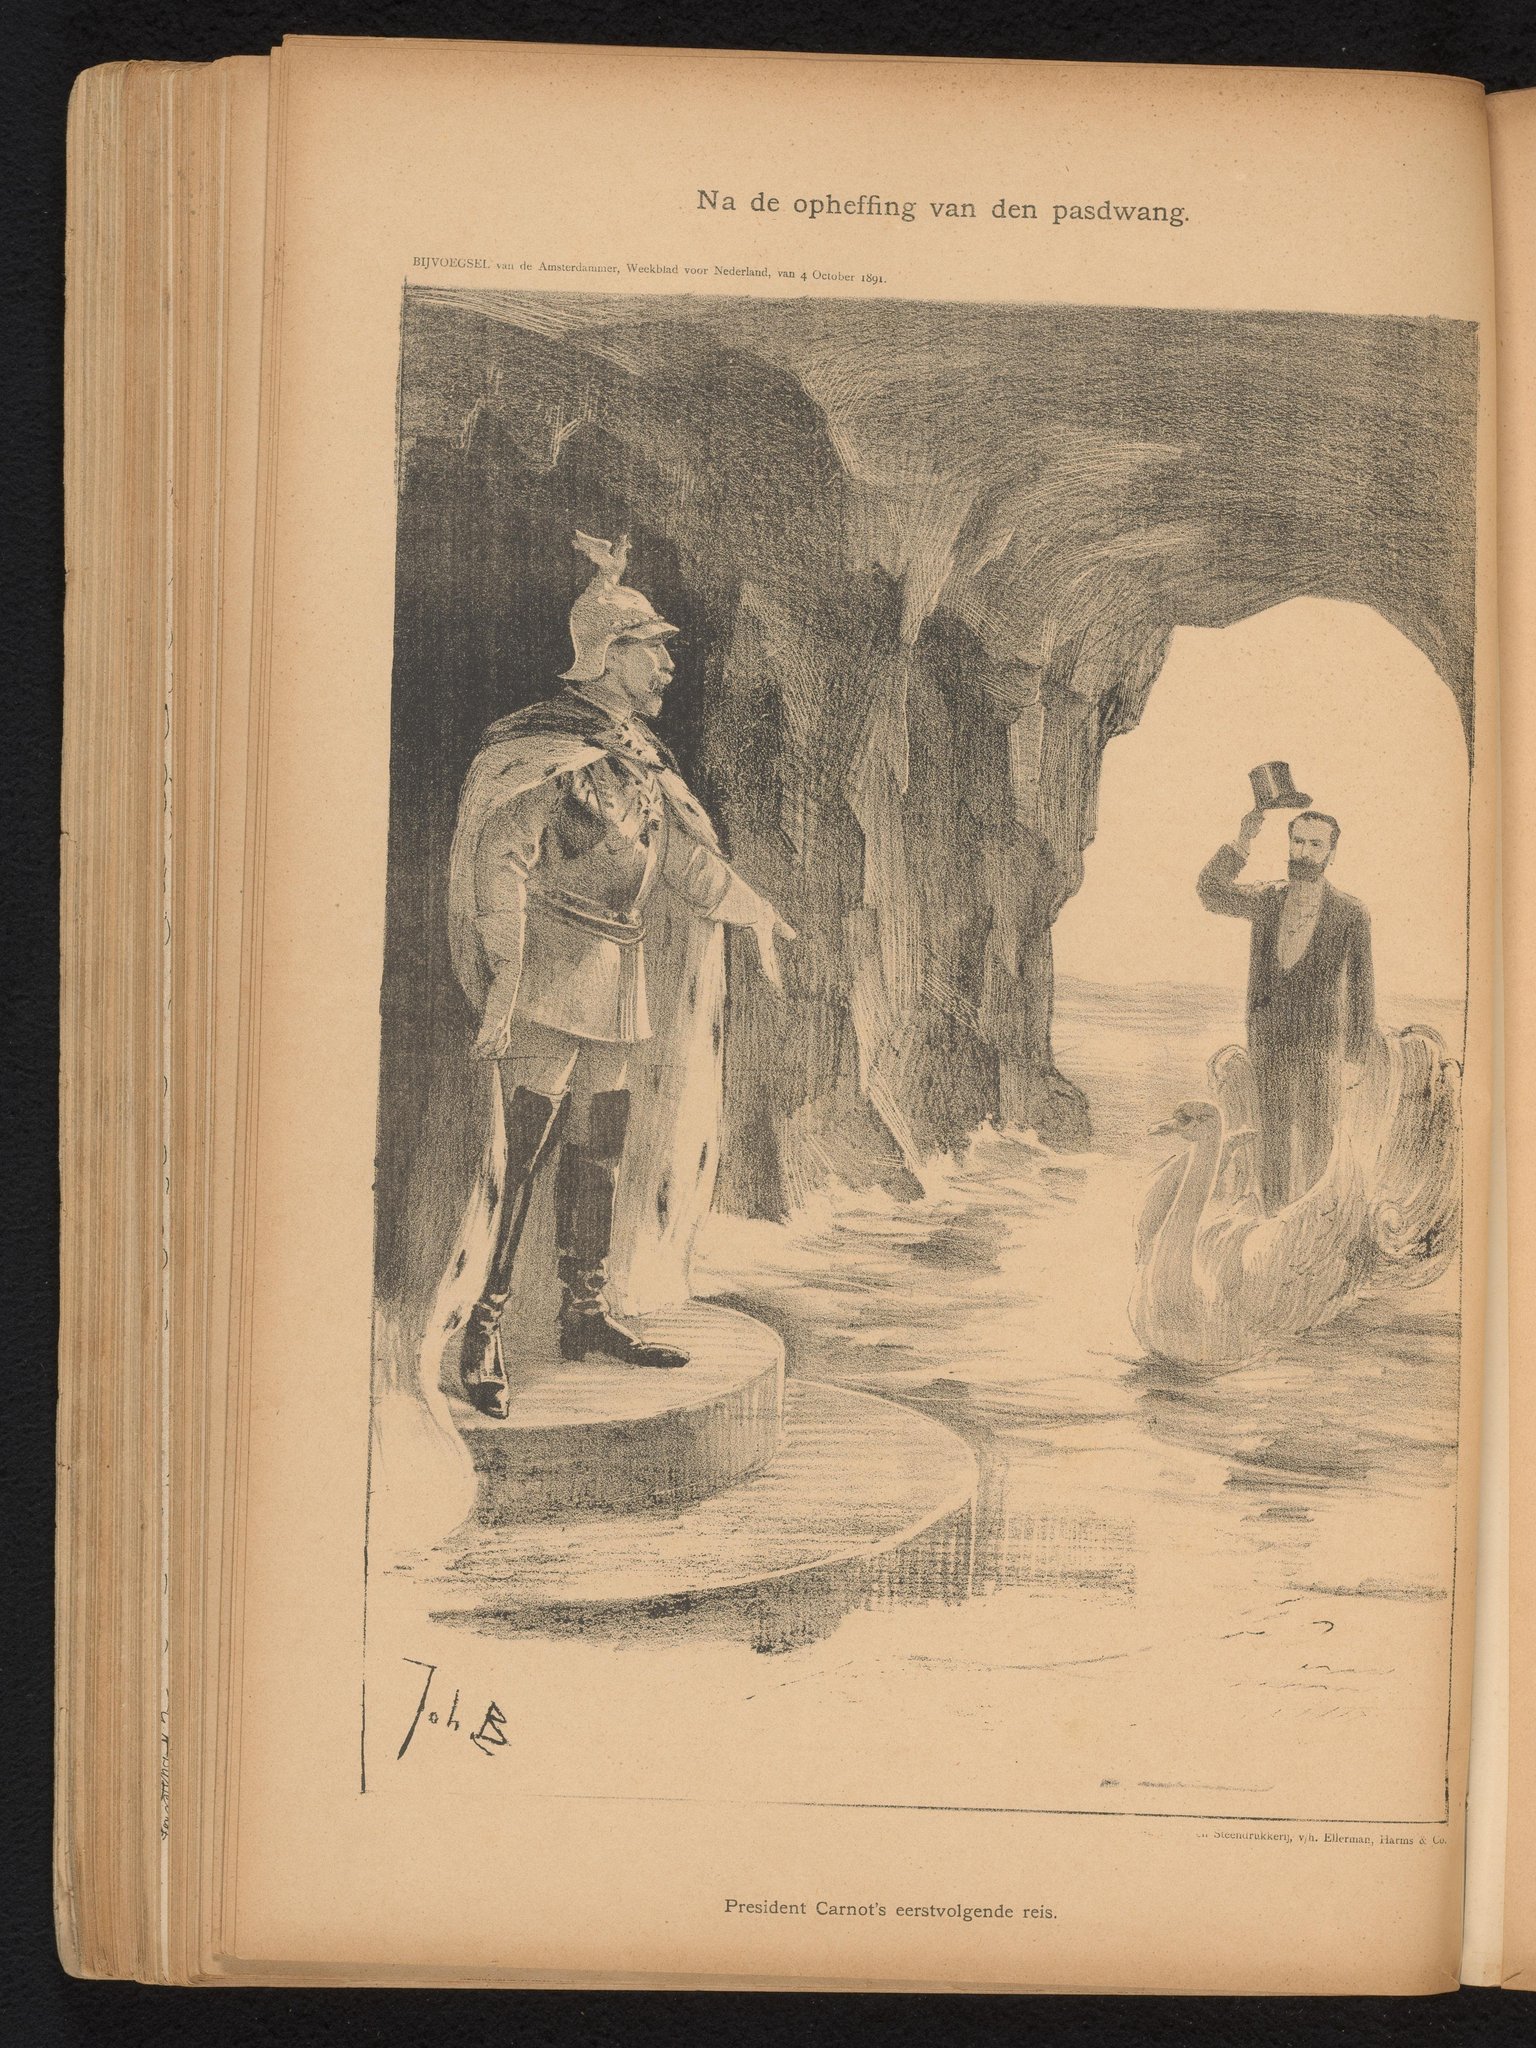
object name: cartoon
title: Na de opheffing van den pasdwang. / President Carnot's eerstvolgende reis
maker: johan braakensiek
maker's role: draughtsman, print maker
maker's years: 1858-1940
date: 1891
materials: paper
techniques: lithograph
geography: netherlands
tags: wilhelm ii (keizer van duitsland), water-birds: swan, swan knight, political caricatures and satires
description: De Franse president Carnot komt als de Zwaanridder op bezoek in de grot bij de Duitse keizer Wilhelm II.